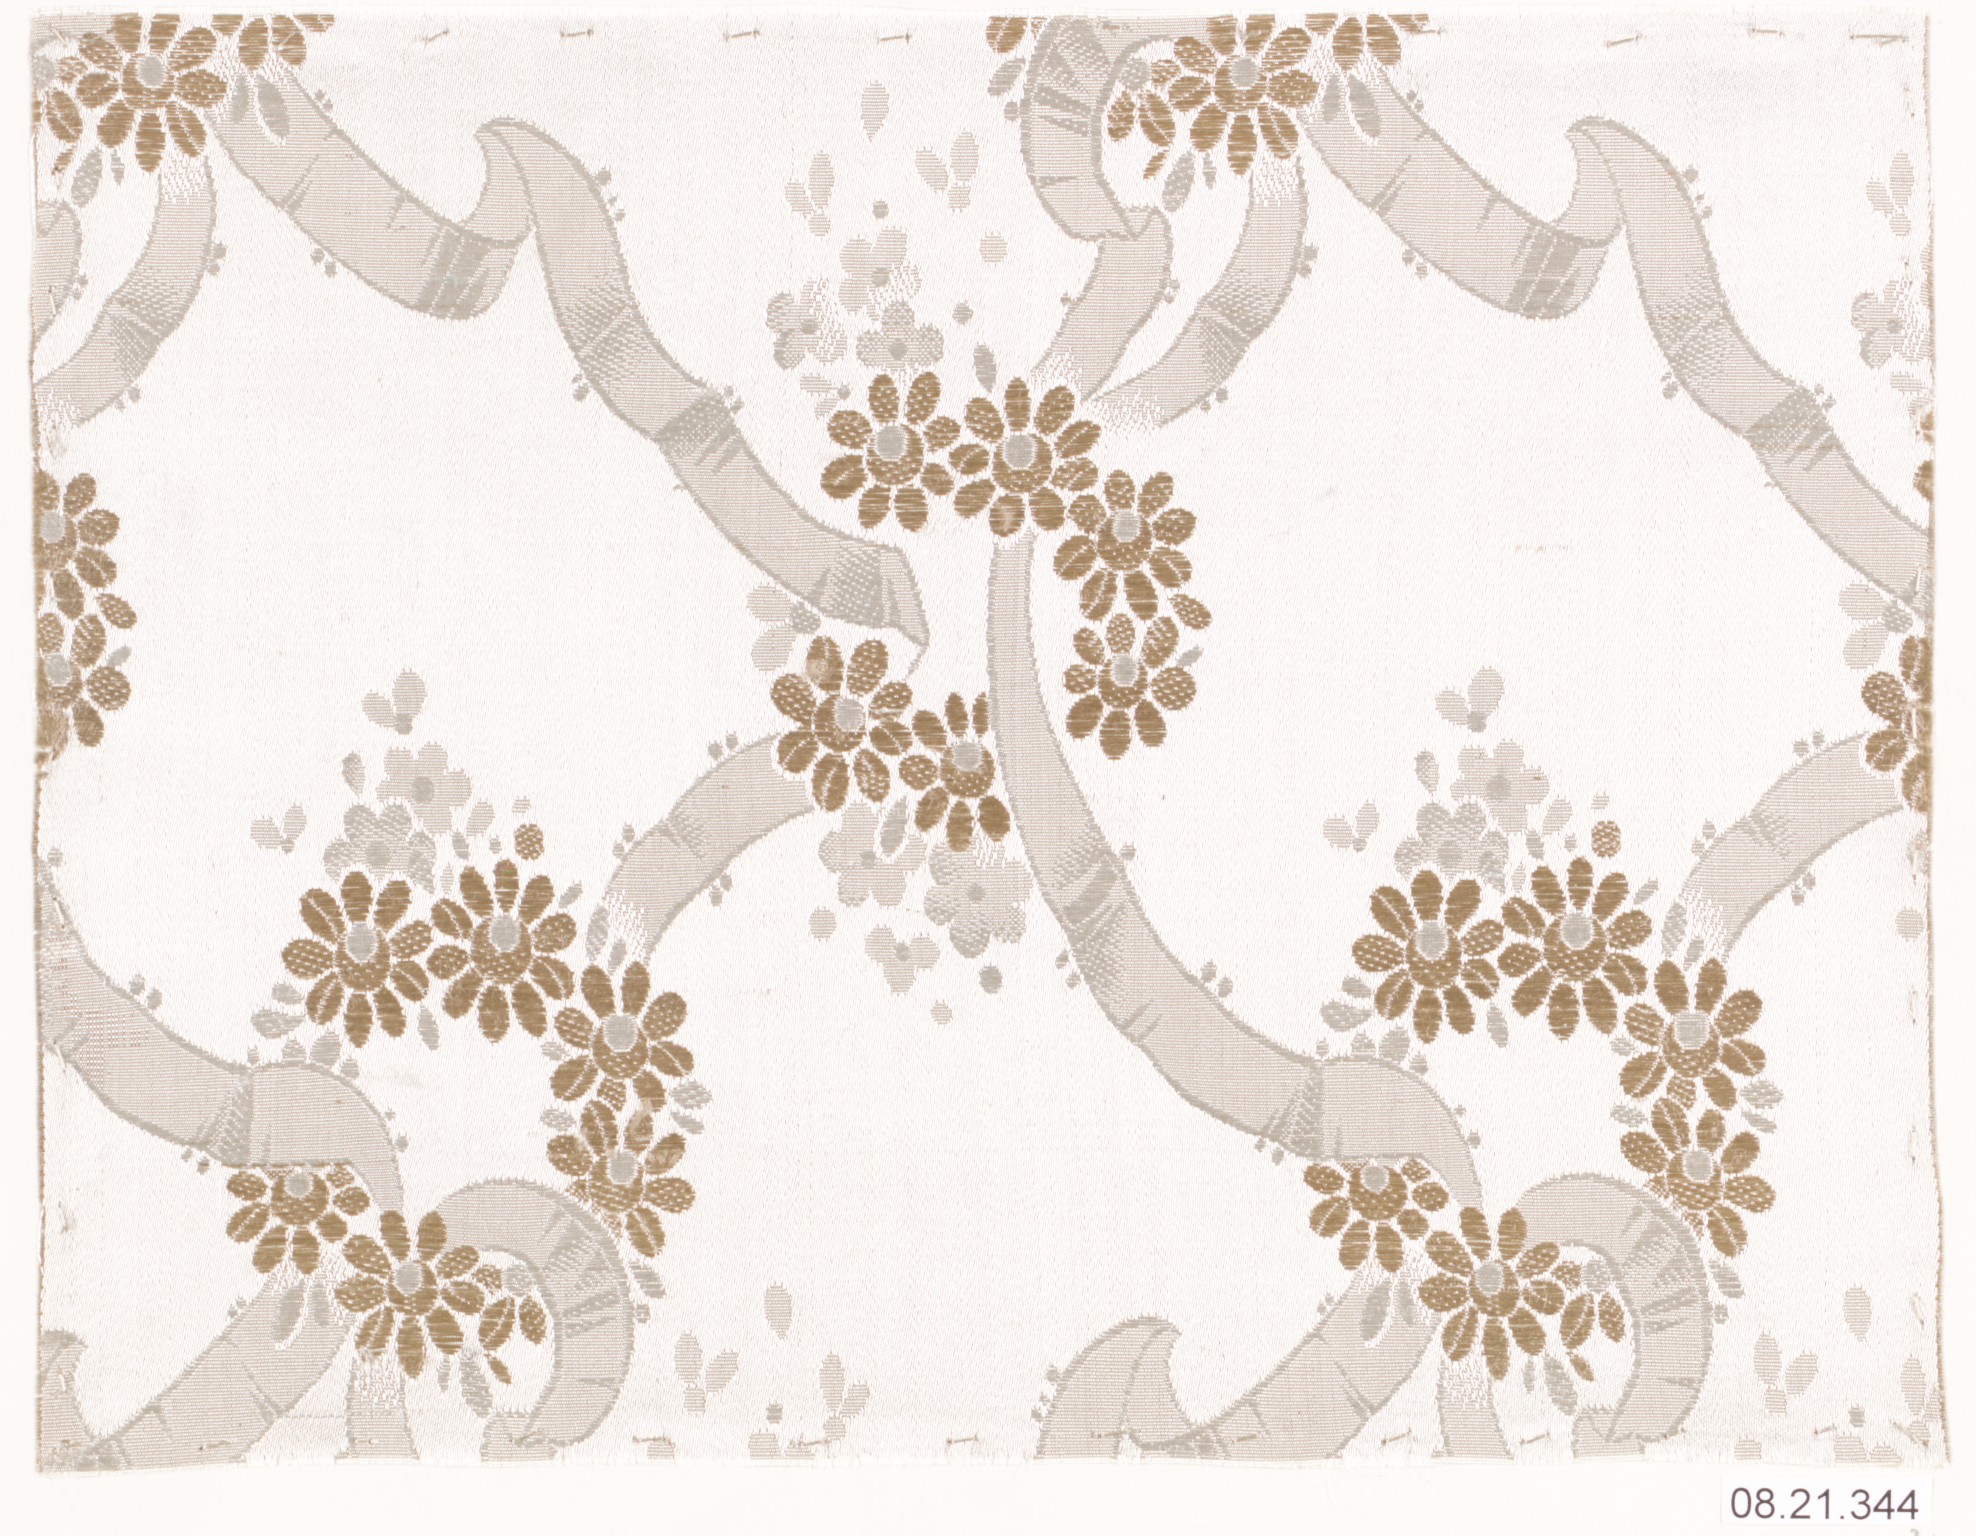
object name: textile sample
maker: Anonymous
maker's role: designer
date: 1900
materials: silk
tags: flowers